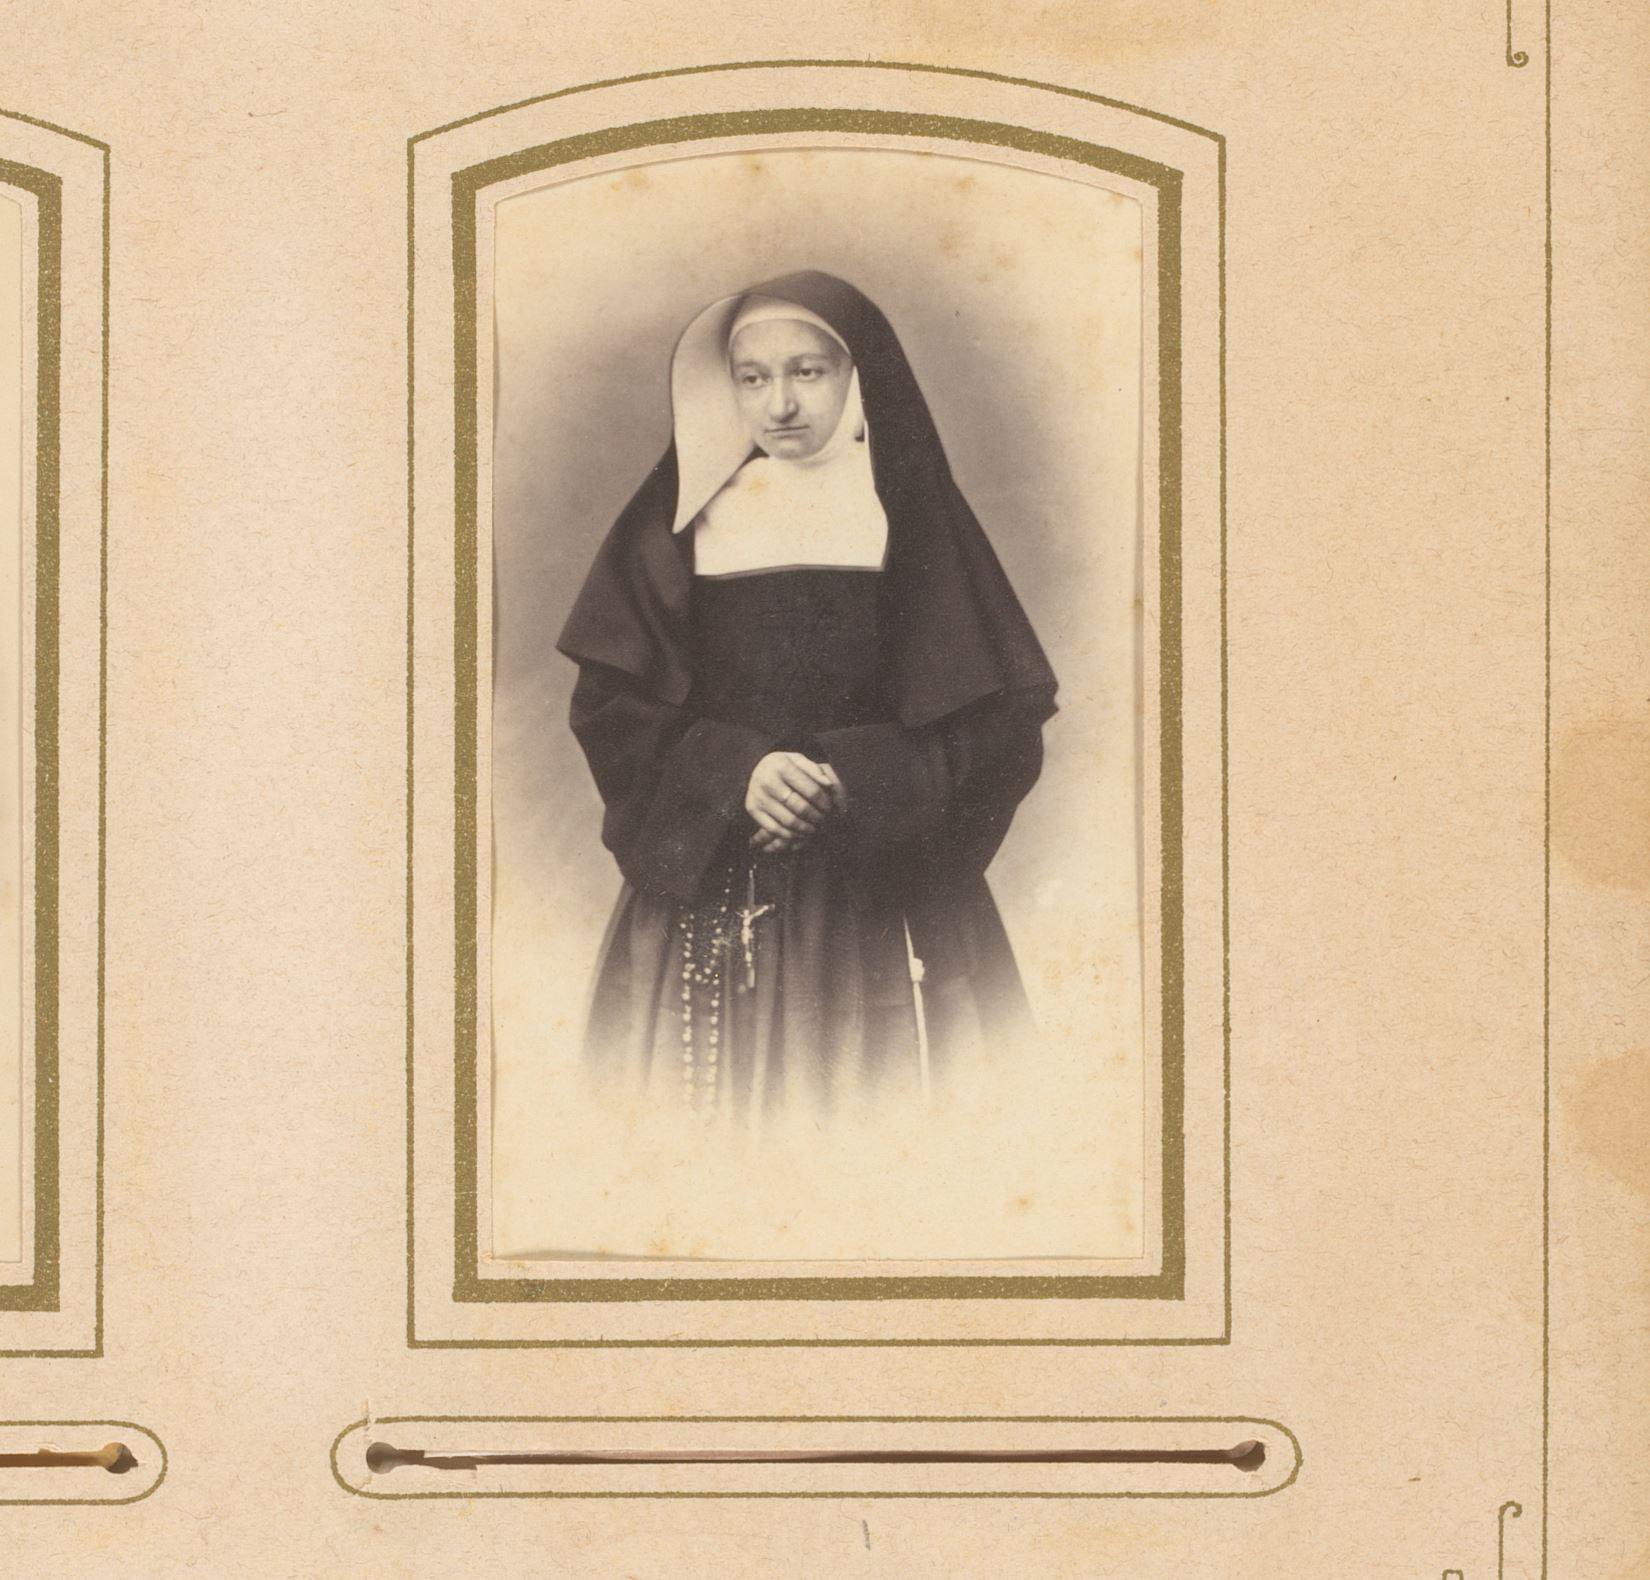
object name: photograph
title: Portret van een jonge non met rozenkrans in de hand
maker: Anonymous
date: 1860-1900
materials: cardboard, photographic support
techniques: albumen print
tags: historical persons - bb - woman, nun(s), aids for prayer, e.g. rosary